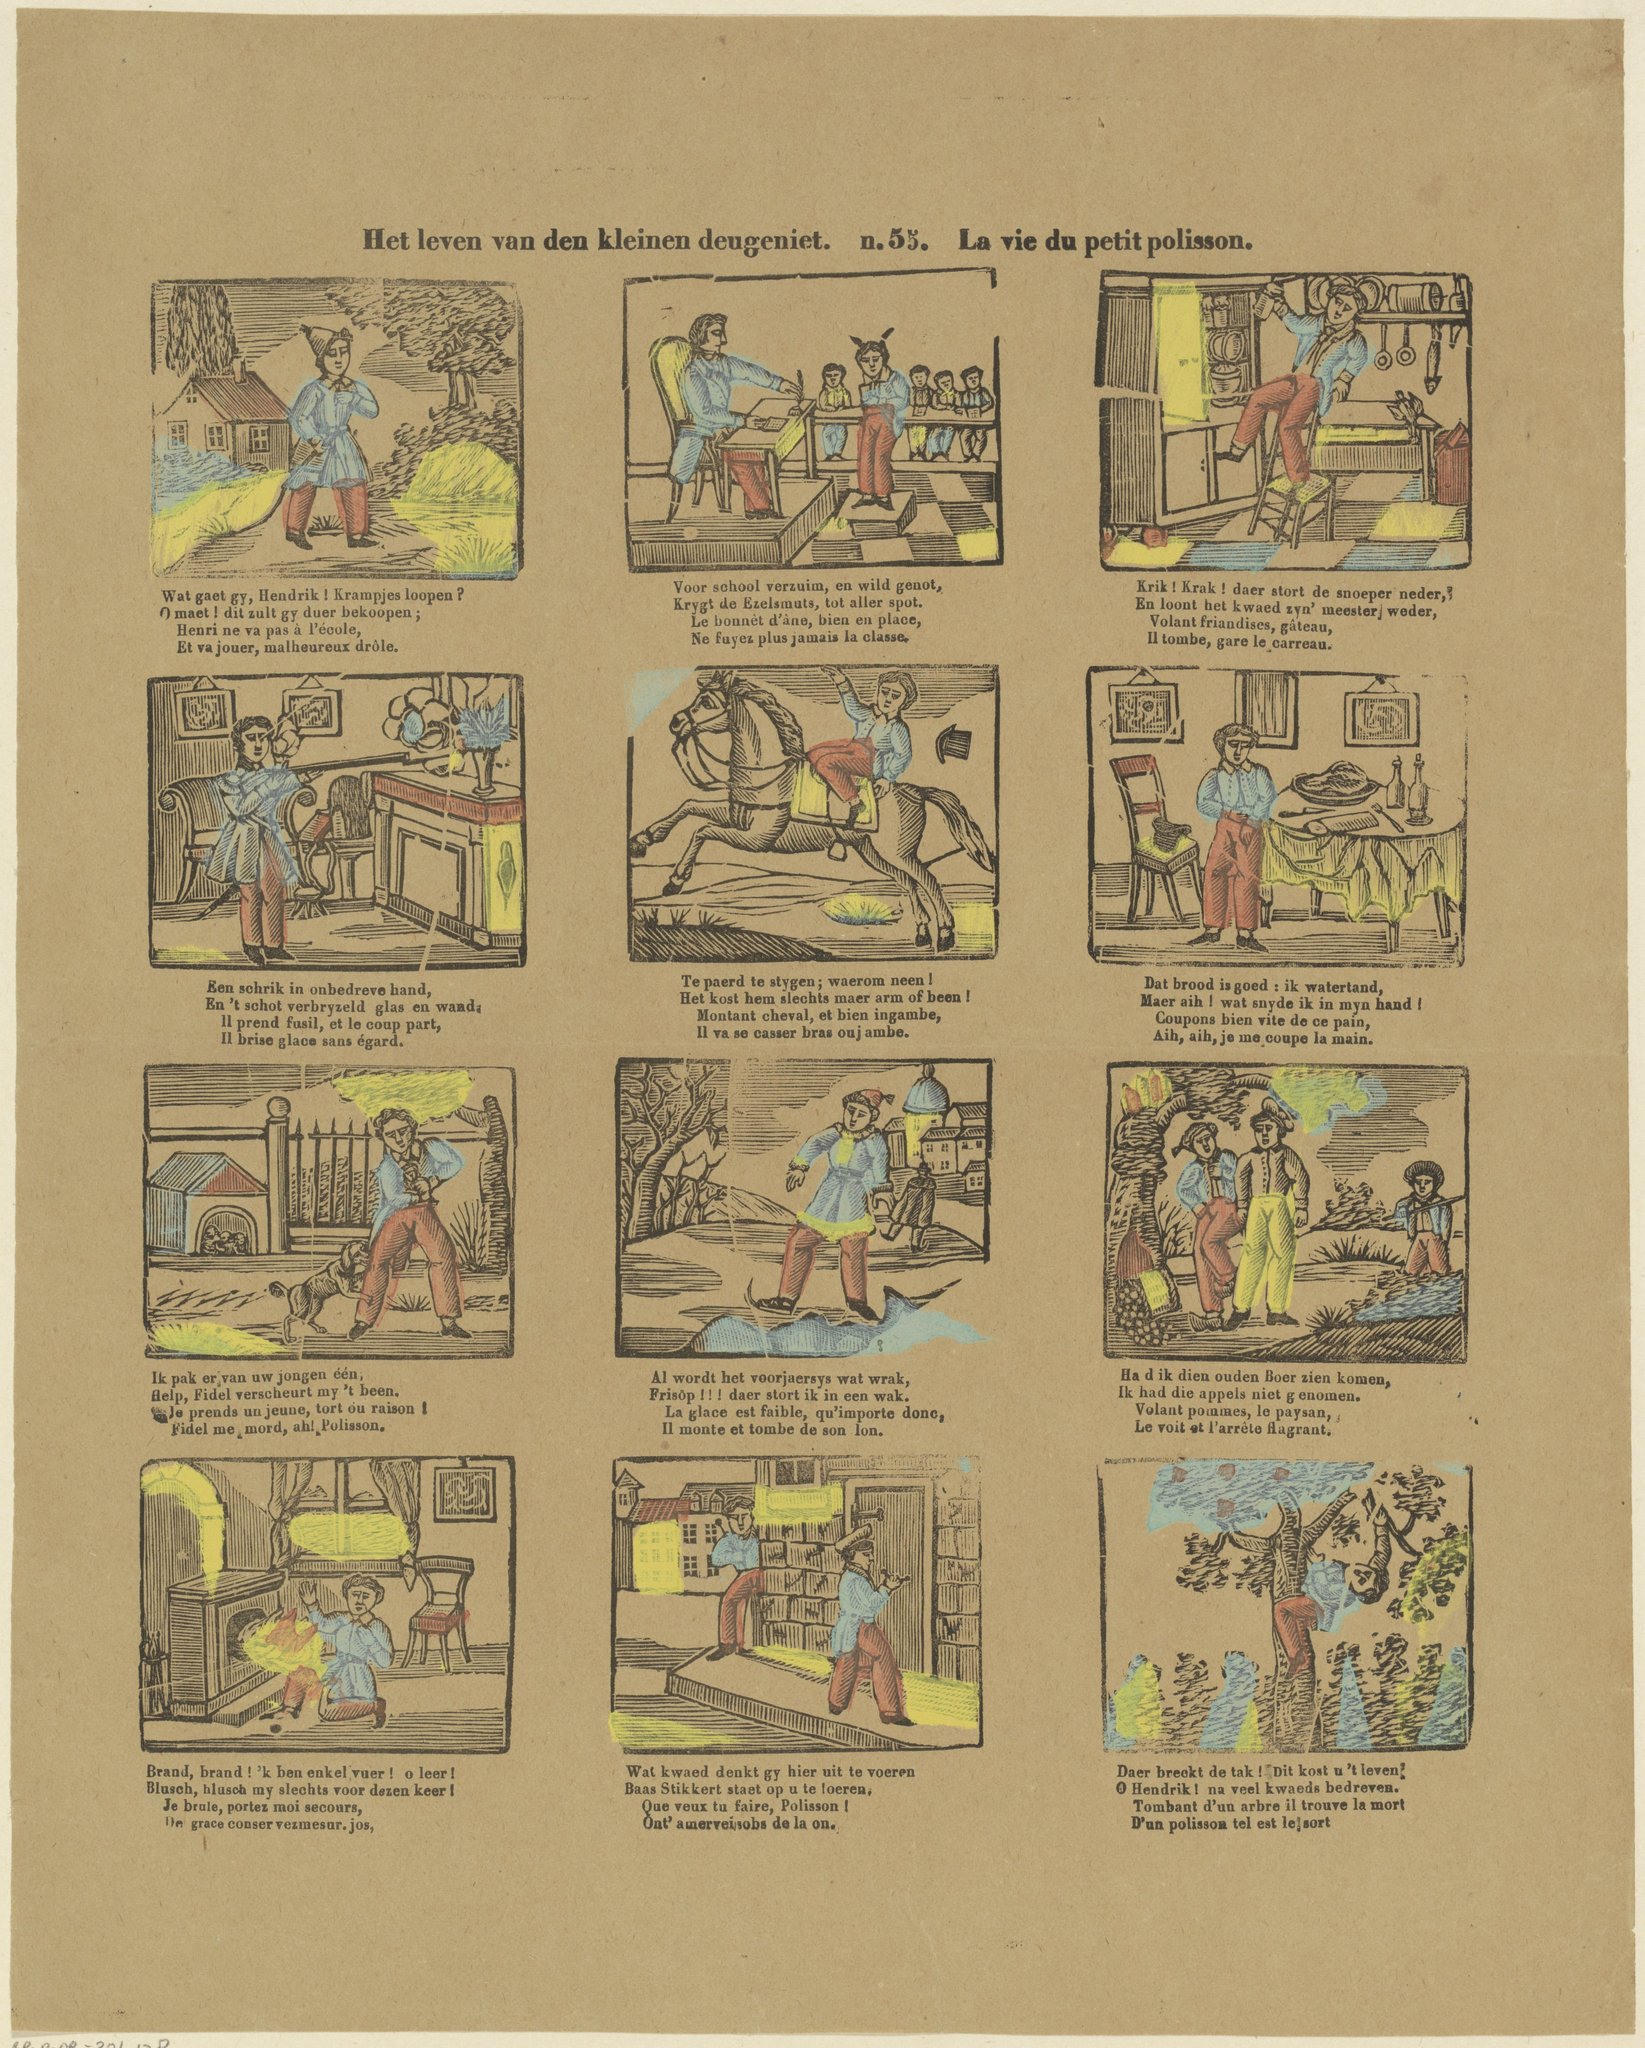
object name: print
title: Het leven van den kleinen deugeniet / La vie du petit polisson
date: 1866-1902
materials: paper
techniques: colour, letterpress printing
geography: europe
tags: mischief-making play, child, bad behaviour, little household accidents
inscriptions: collector's mark: Lugt 2760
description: Blad met 12 voorstellingen van de streken en ongelukken van de kleine deugniet Hendrik. Onder elke voorstelling een tweeregelig vers in het Nederlands en het Frans. Genummerd midden boven: n. 55.